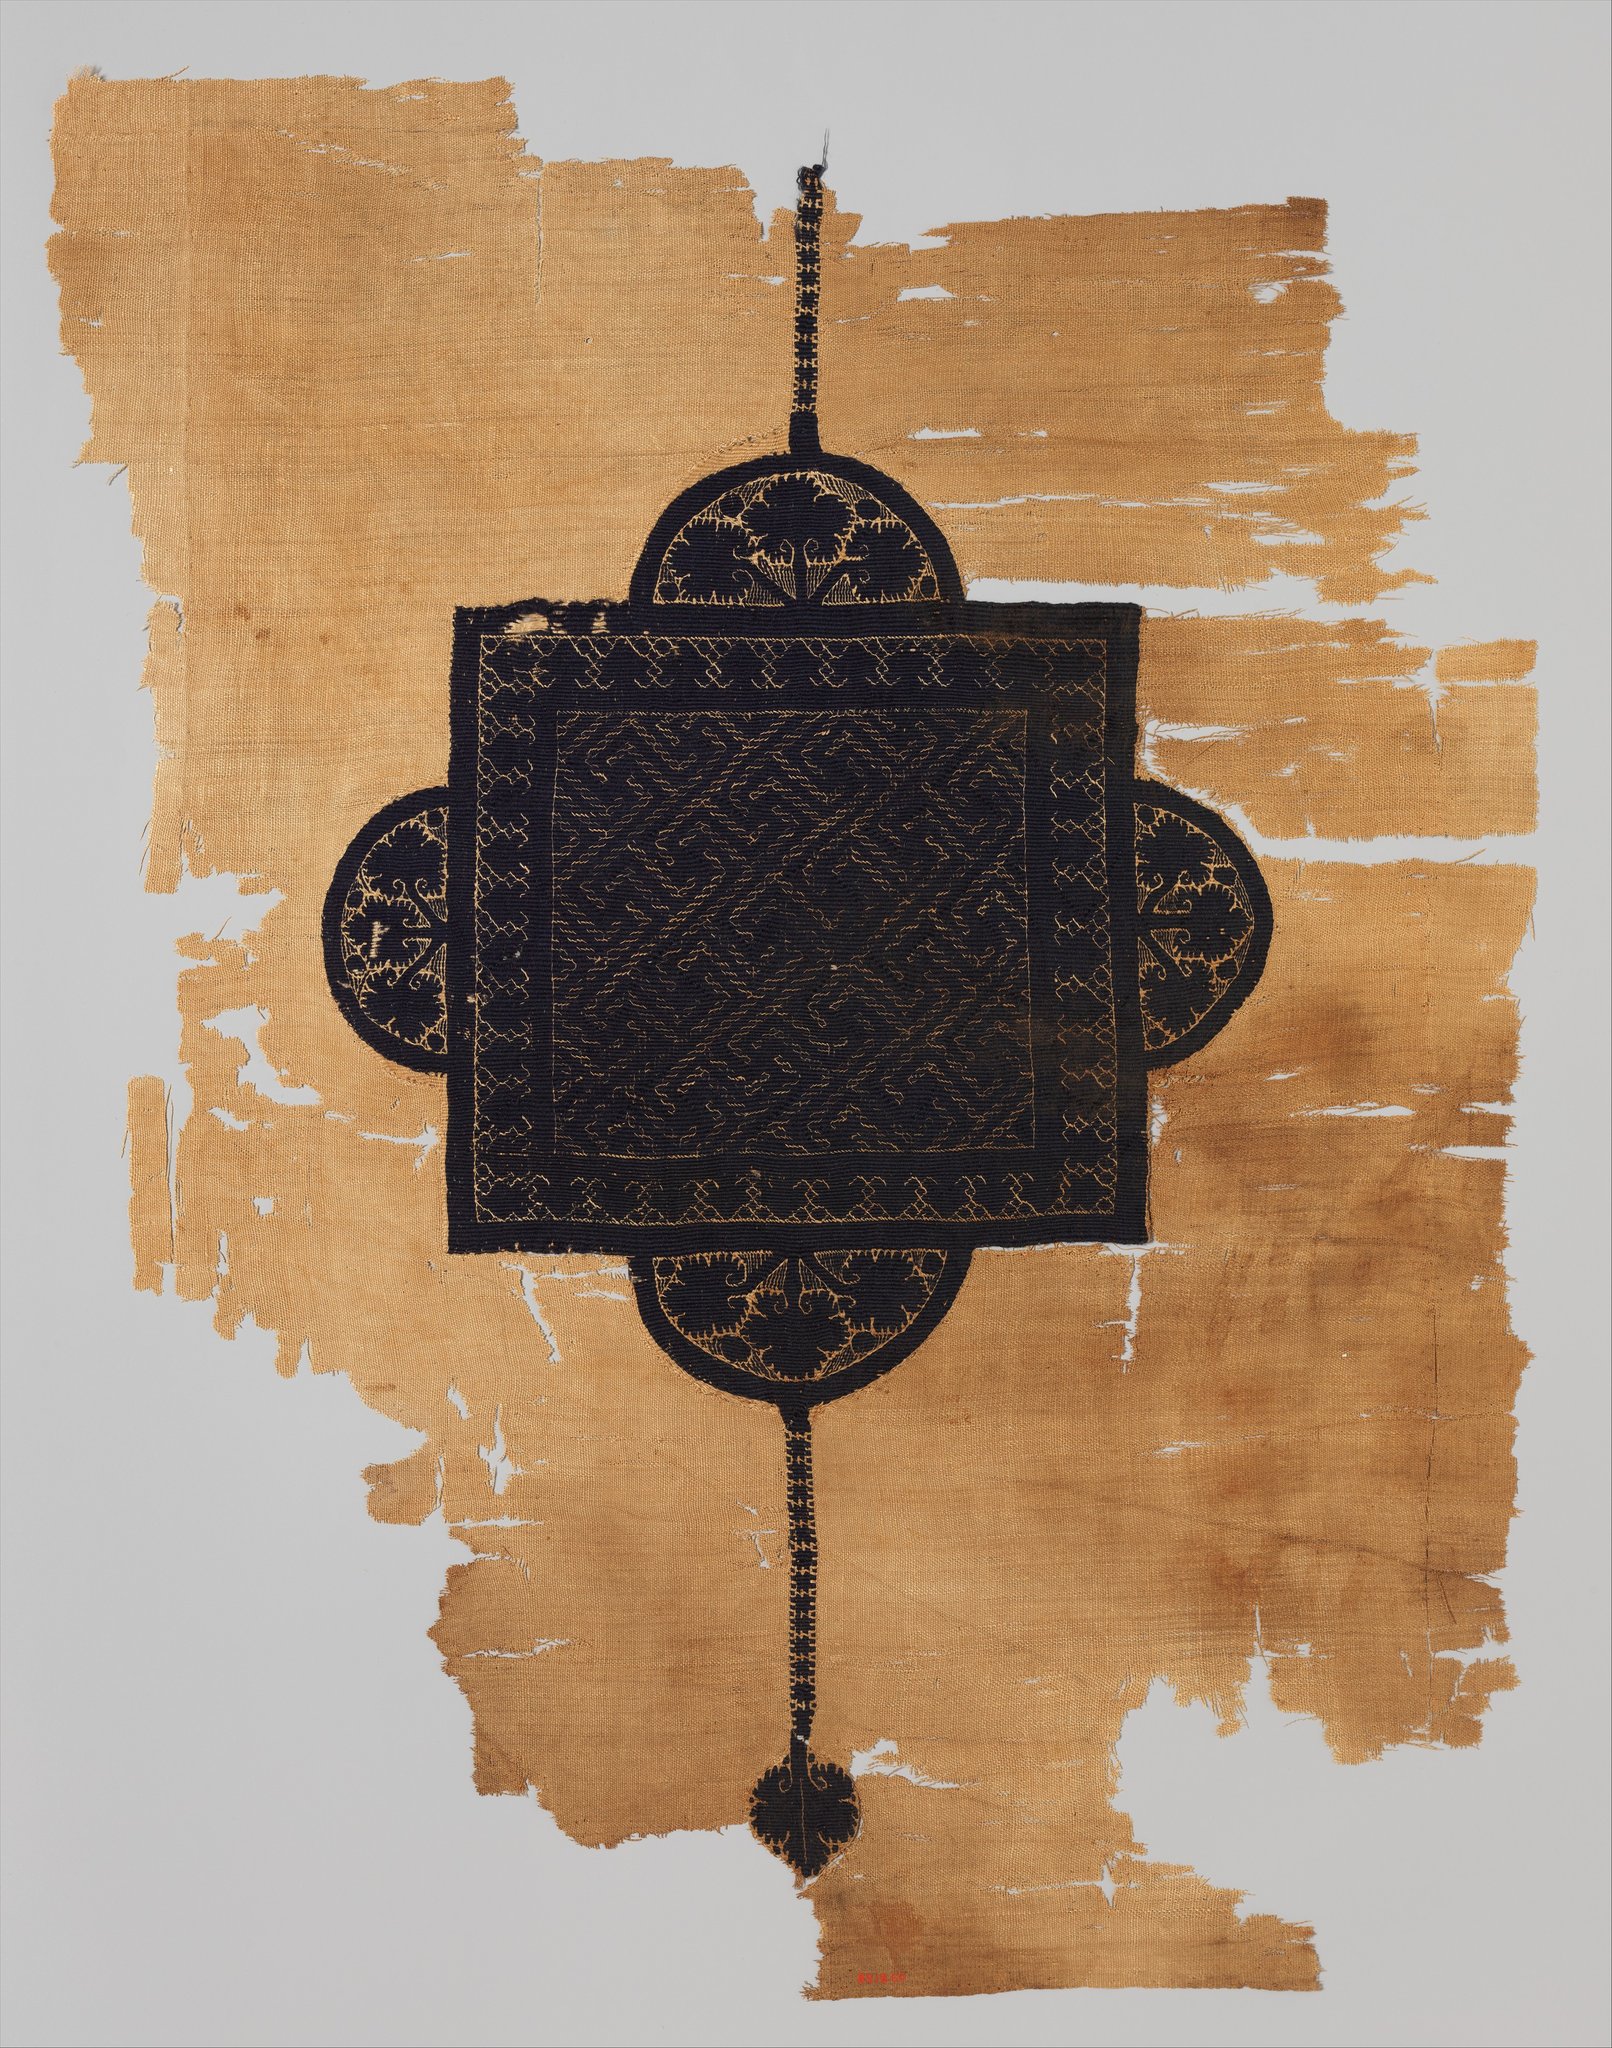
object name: textile fragment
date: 201-400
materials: linen, wool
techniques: weave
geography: egypt